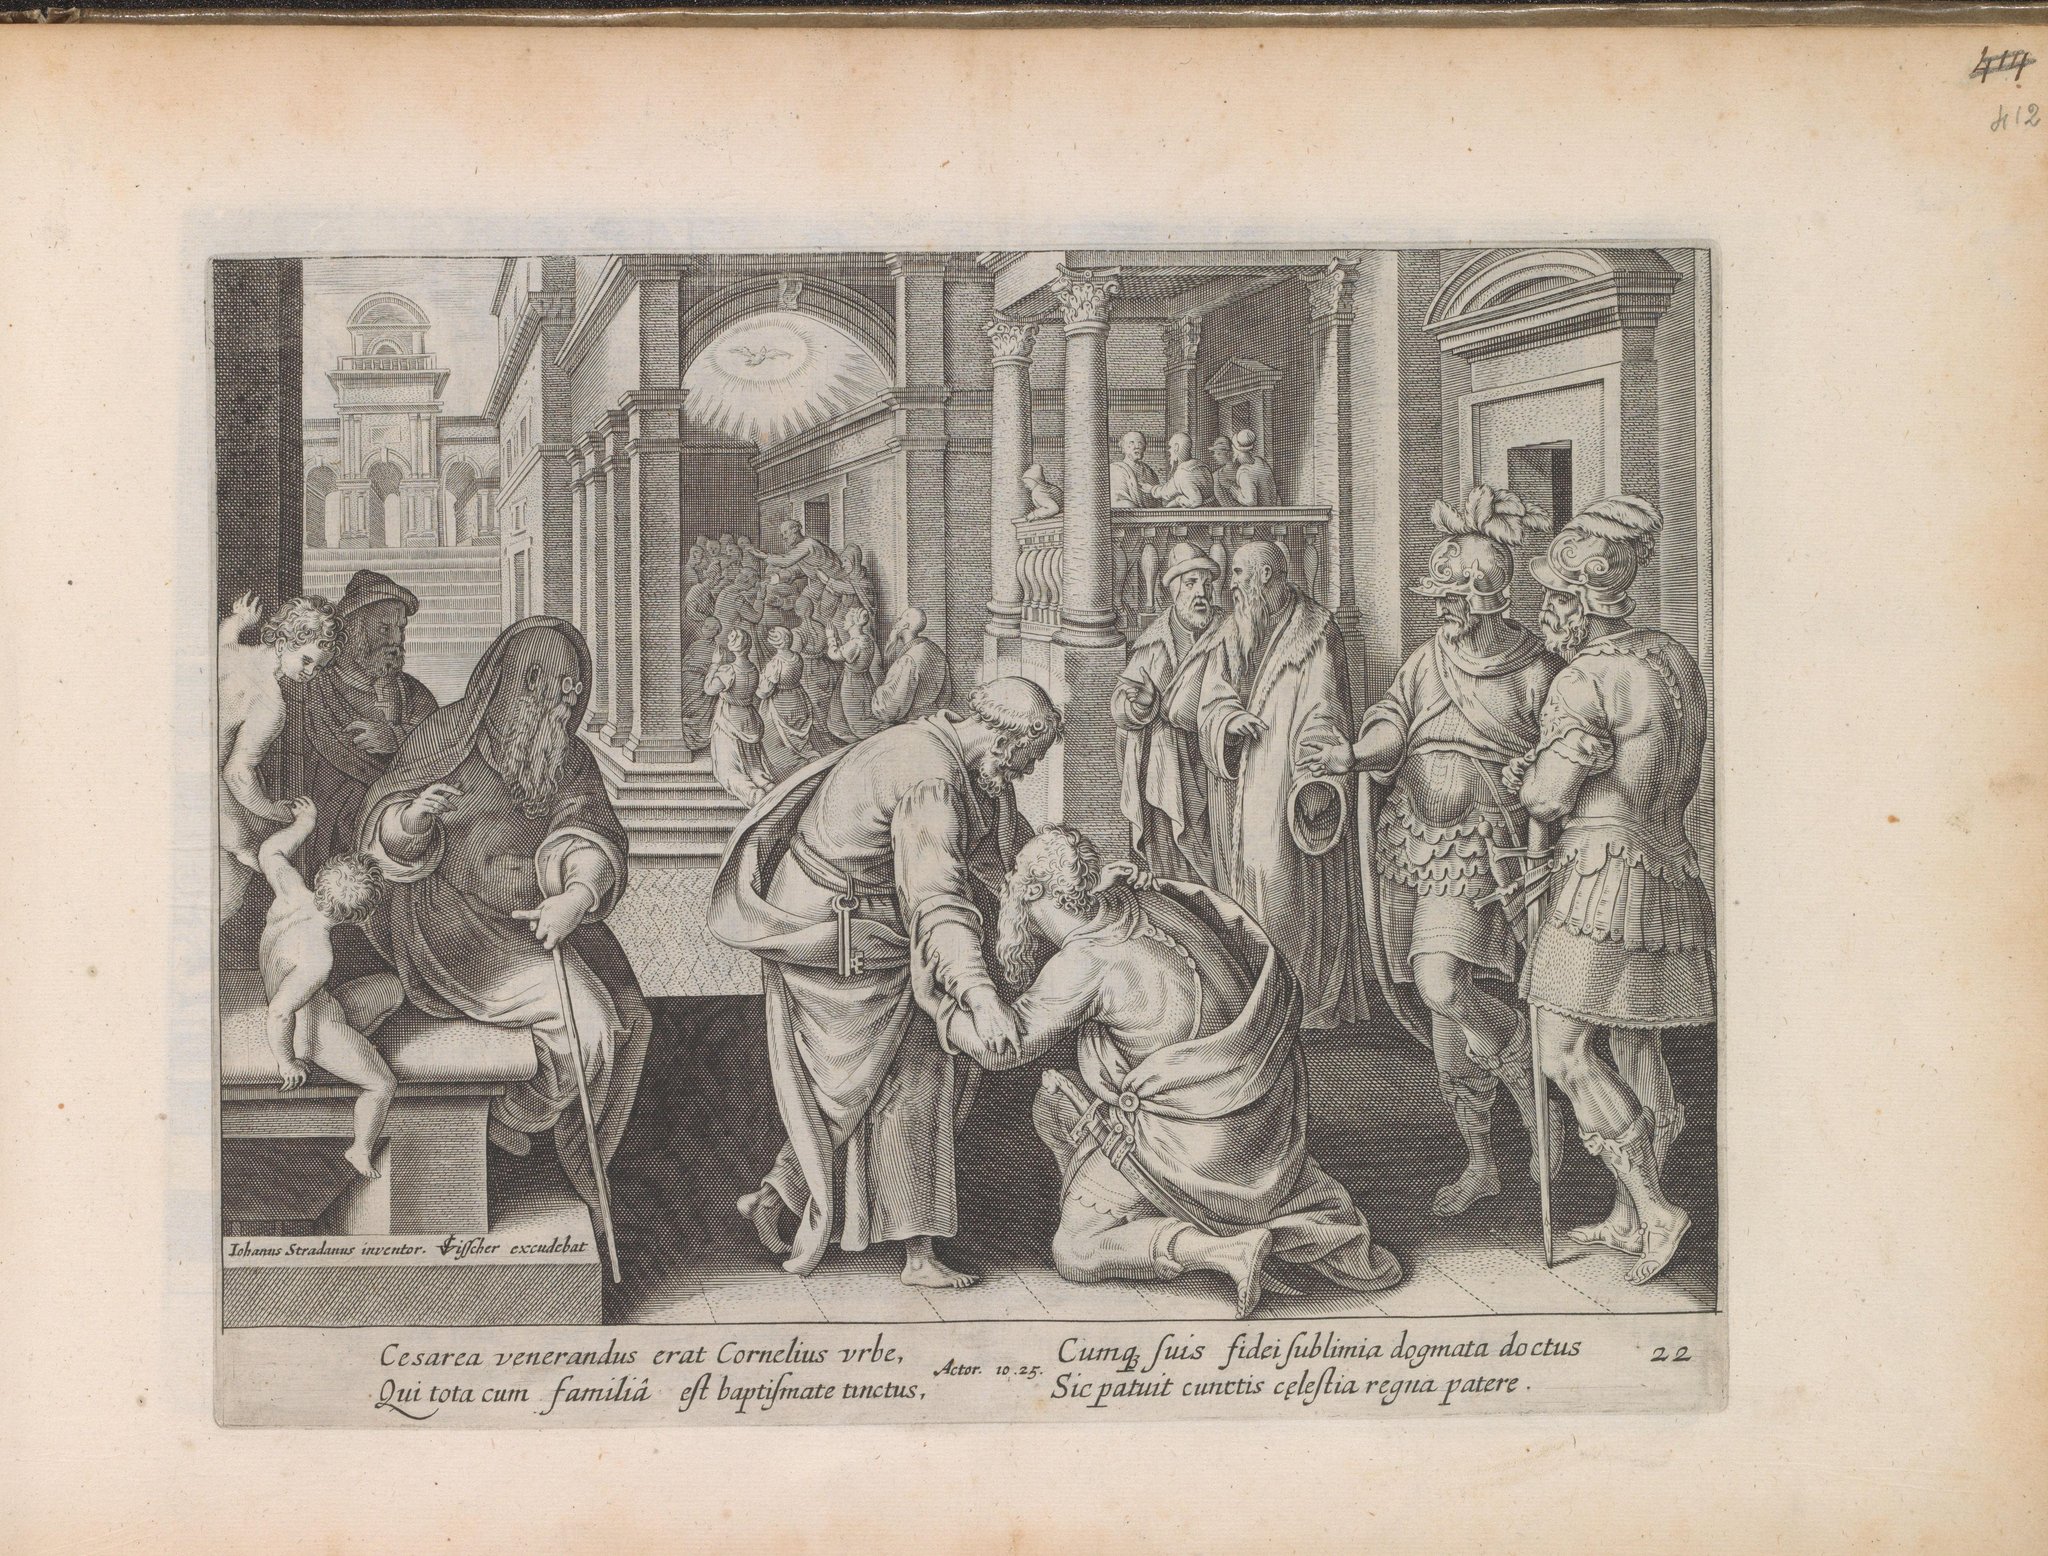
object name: album leaf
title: Acta Apostolorum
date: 1643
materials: paper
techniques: engraving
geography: amsterdam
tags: peter and cornelius the centurion (acts 10), peter in the house of cornelius: the holy ghost descends upon cornelius and his family, who are baptized by peter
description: De centurio Cornelius knielt voor de apostel Petrus, maar Petrus maant hem om op te staan omdat hij ook maar een mens is. Op de achtergrond preekt Petrus voor Cornelius en de rest van zijn familie. De Heilige Geest daalt neer in de vorm van een duif. Onder de voorstelling een verwijzing in het Latijn naar de Bijbeltekst in Hand. 10:25. Deze prent maakt deel uit van een album.